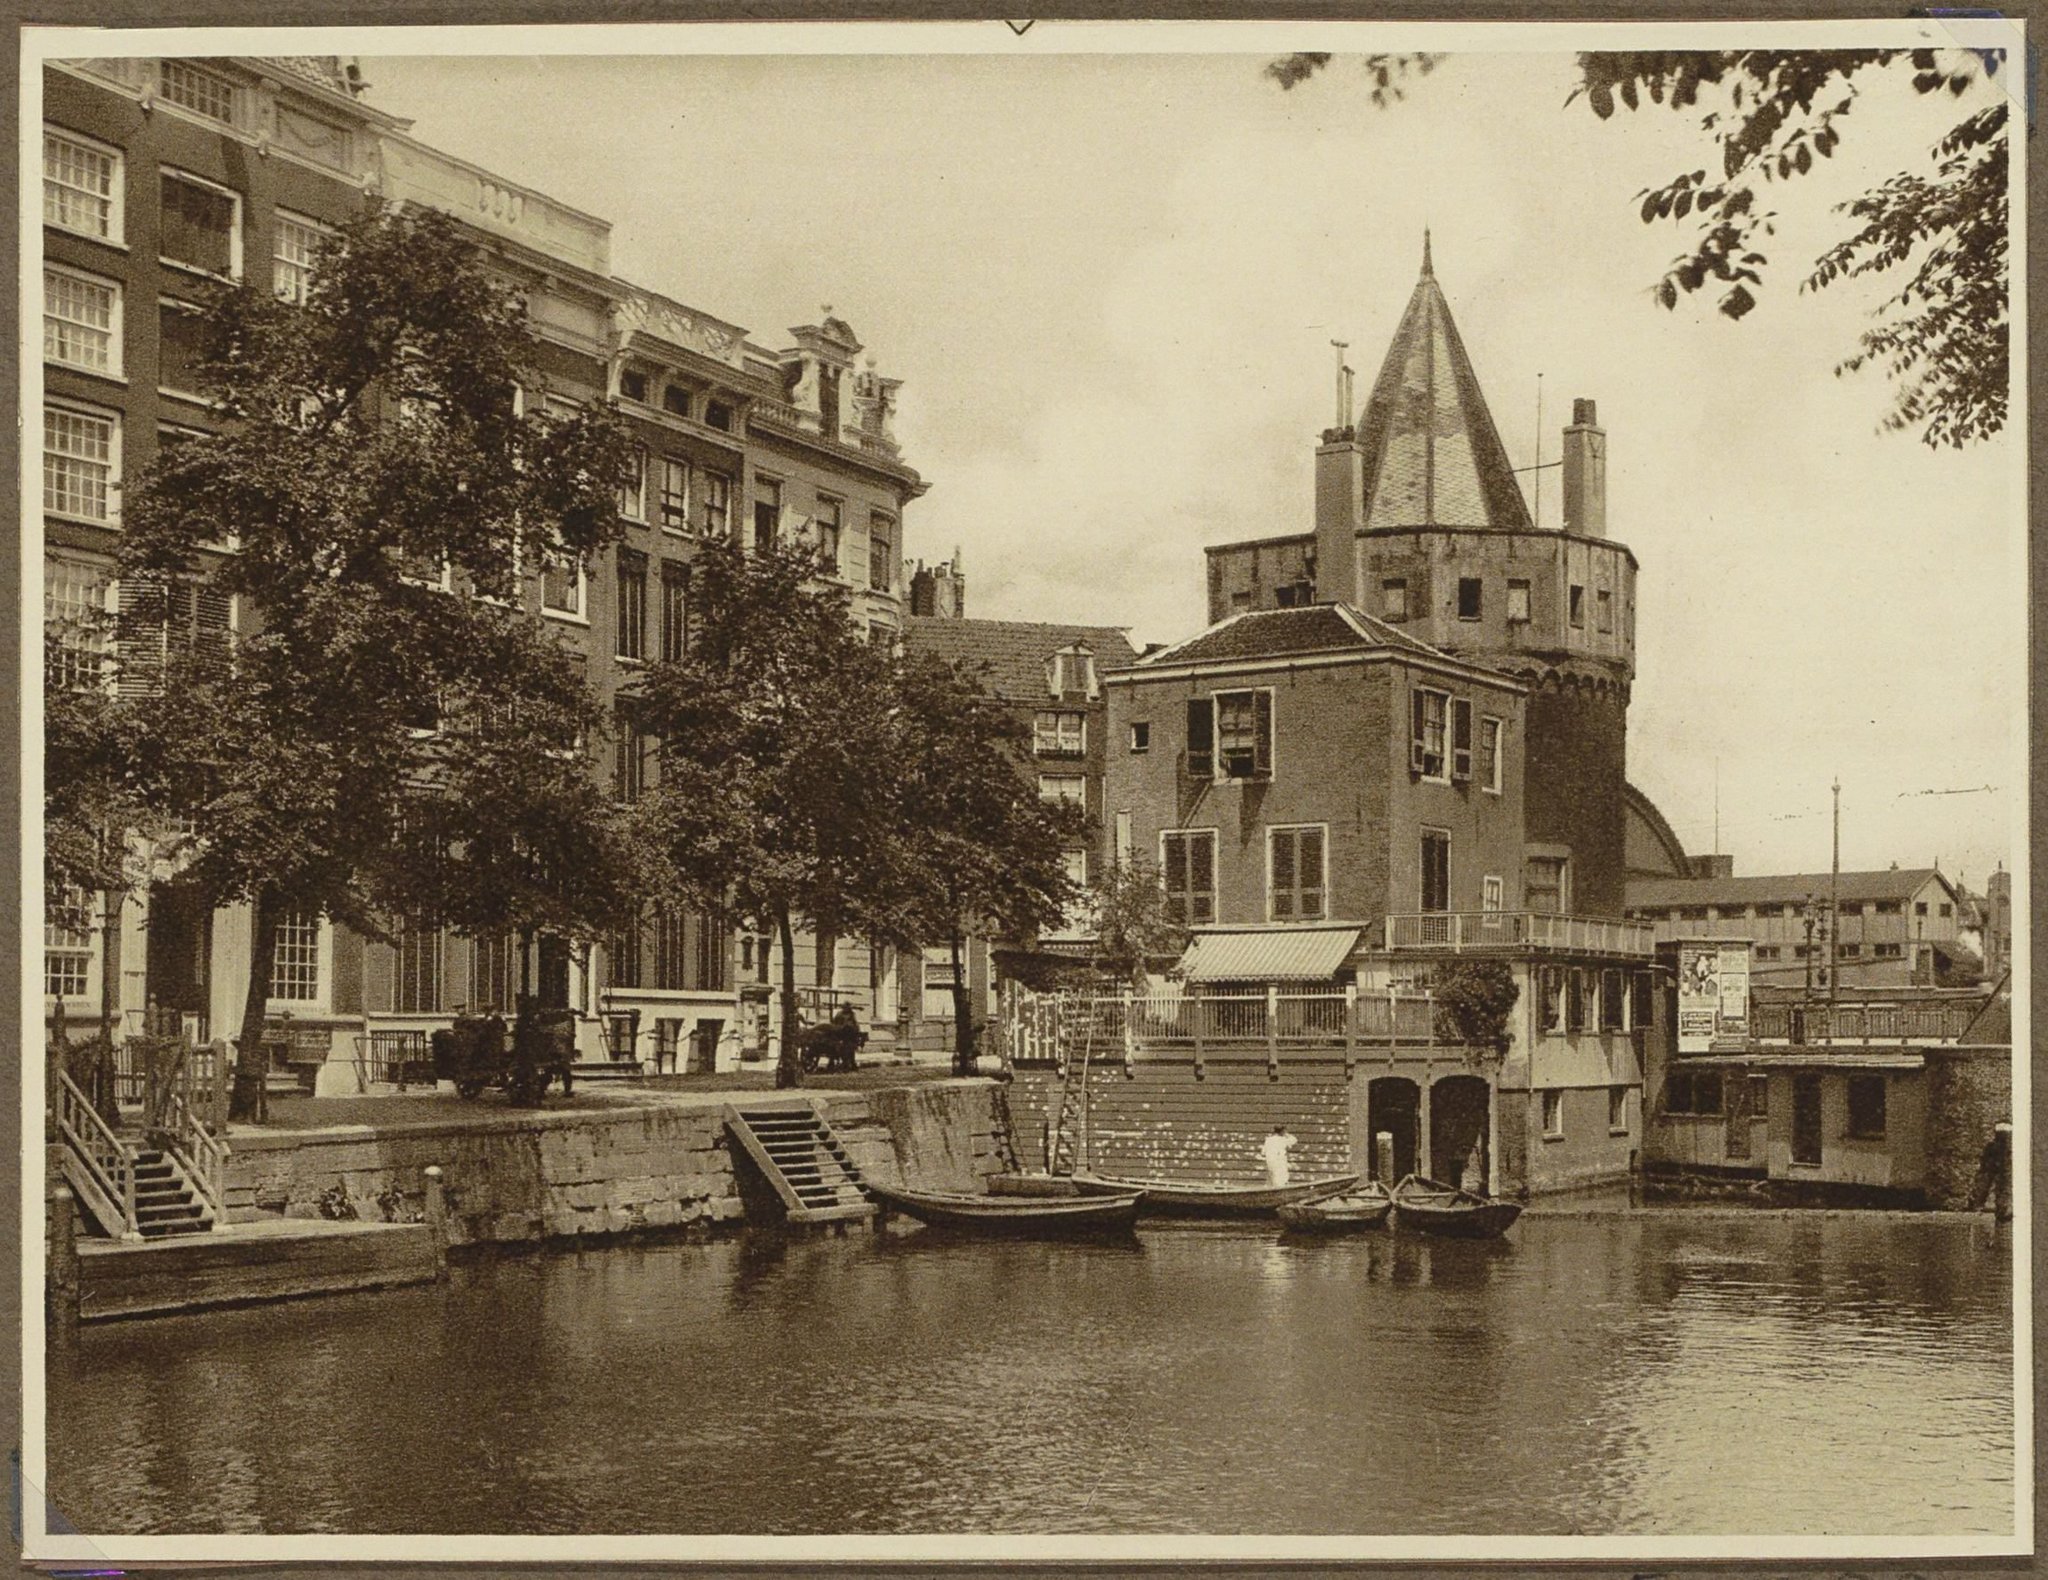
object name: photograph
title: Schreierstoren in Amsterdam, gezien vanaf het water bij de Geldersekade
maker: Anonymous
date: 1910-1930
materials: paper, photographic support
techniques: rotogravure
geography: amsterdam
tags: amsterdam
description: Onderdeel van Album met foto's van Amsterdam en omgeving.